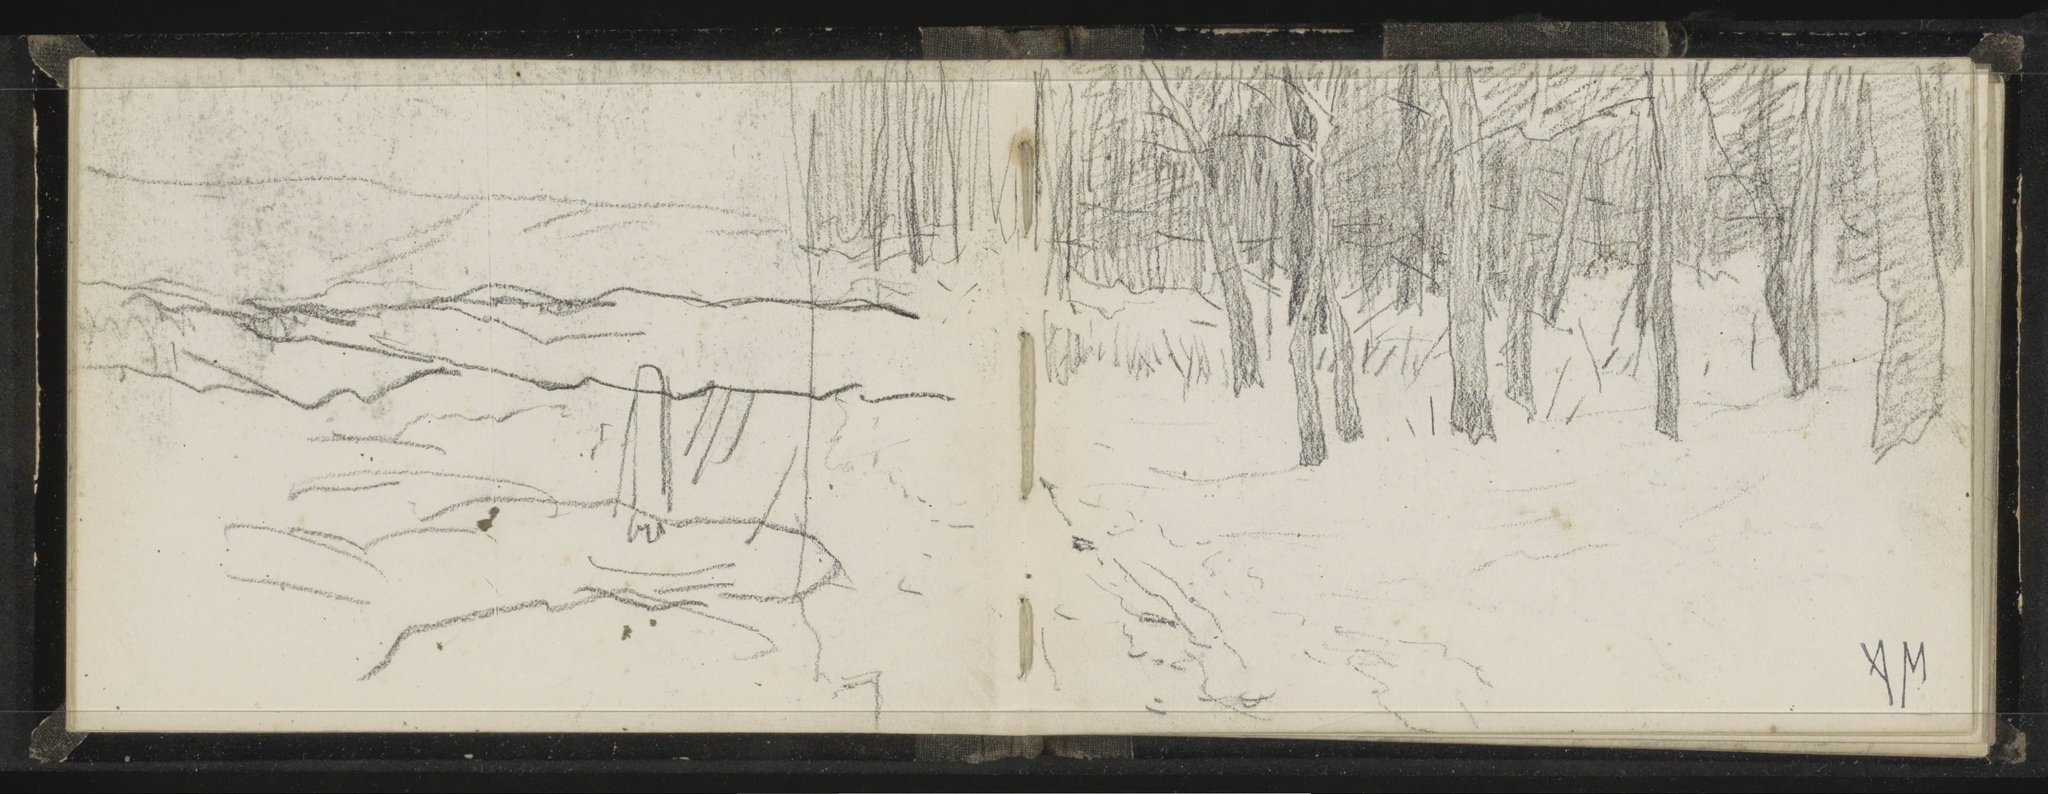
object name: sketchbook leaf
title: Heuvellandschap en de rand van een bos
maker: anton mauve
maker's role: draughtsman, painter, print maker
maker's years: 1838-1888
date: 1848-1888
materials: chalk, paper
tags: low hill country, fringe, edge of the wood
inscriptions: monogram: ‘AM’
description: Blad 3 verso en 4 recto uit een schetsboek met 33 bladen.